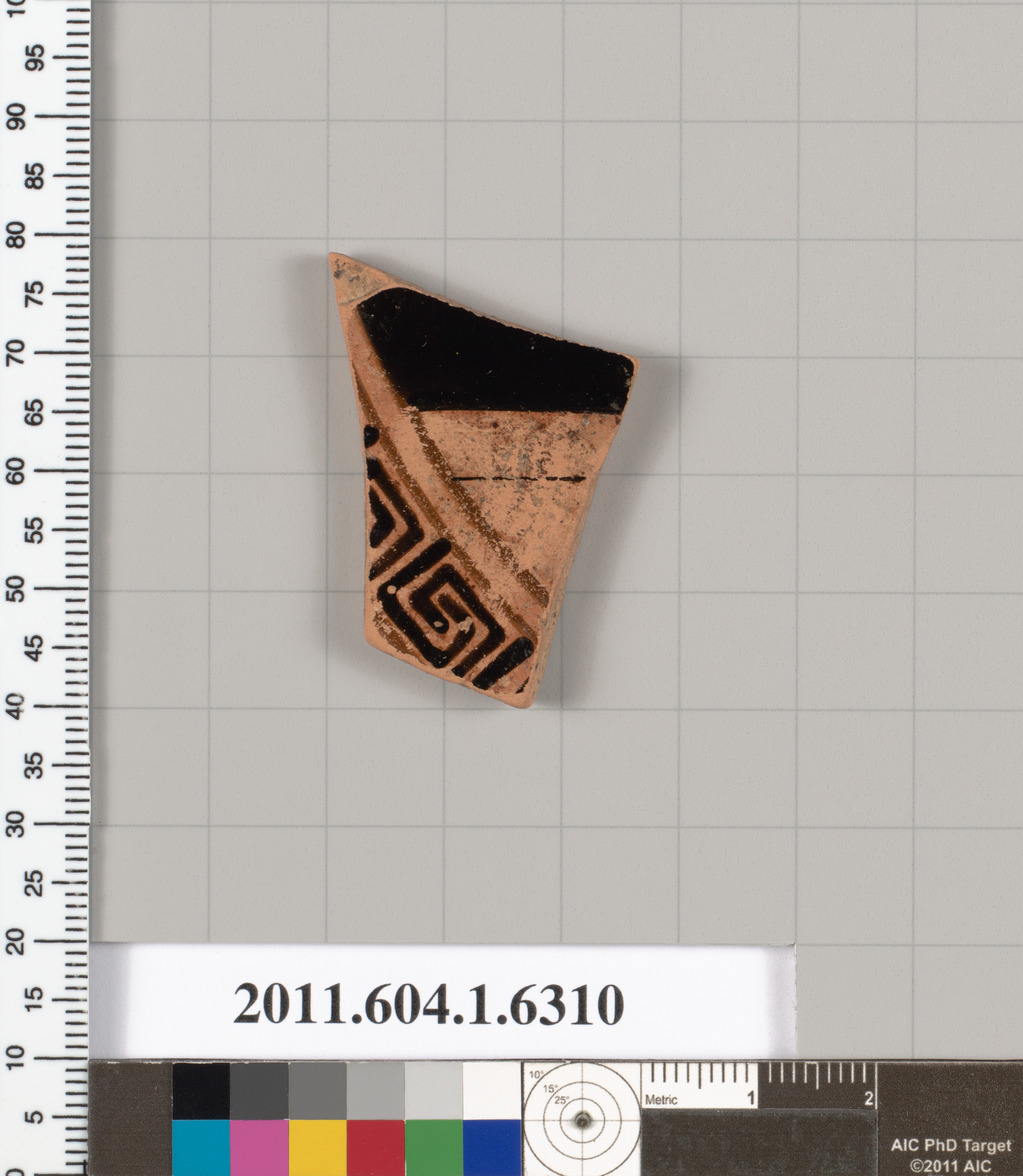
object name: kylix fragment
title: Terracotta fragment of a kylix (drinking cup)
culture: greek, attic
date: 500-480 BCE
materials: terracotta